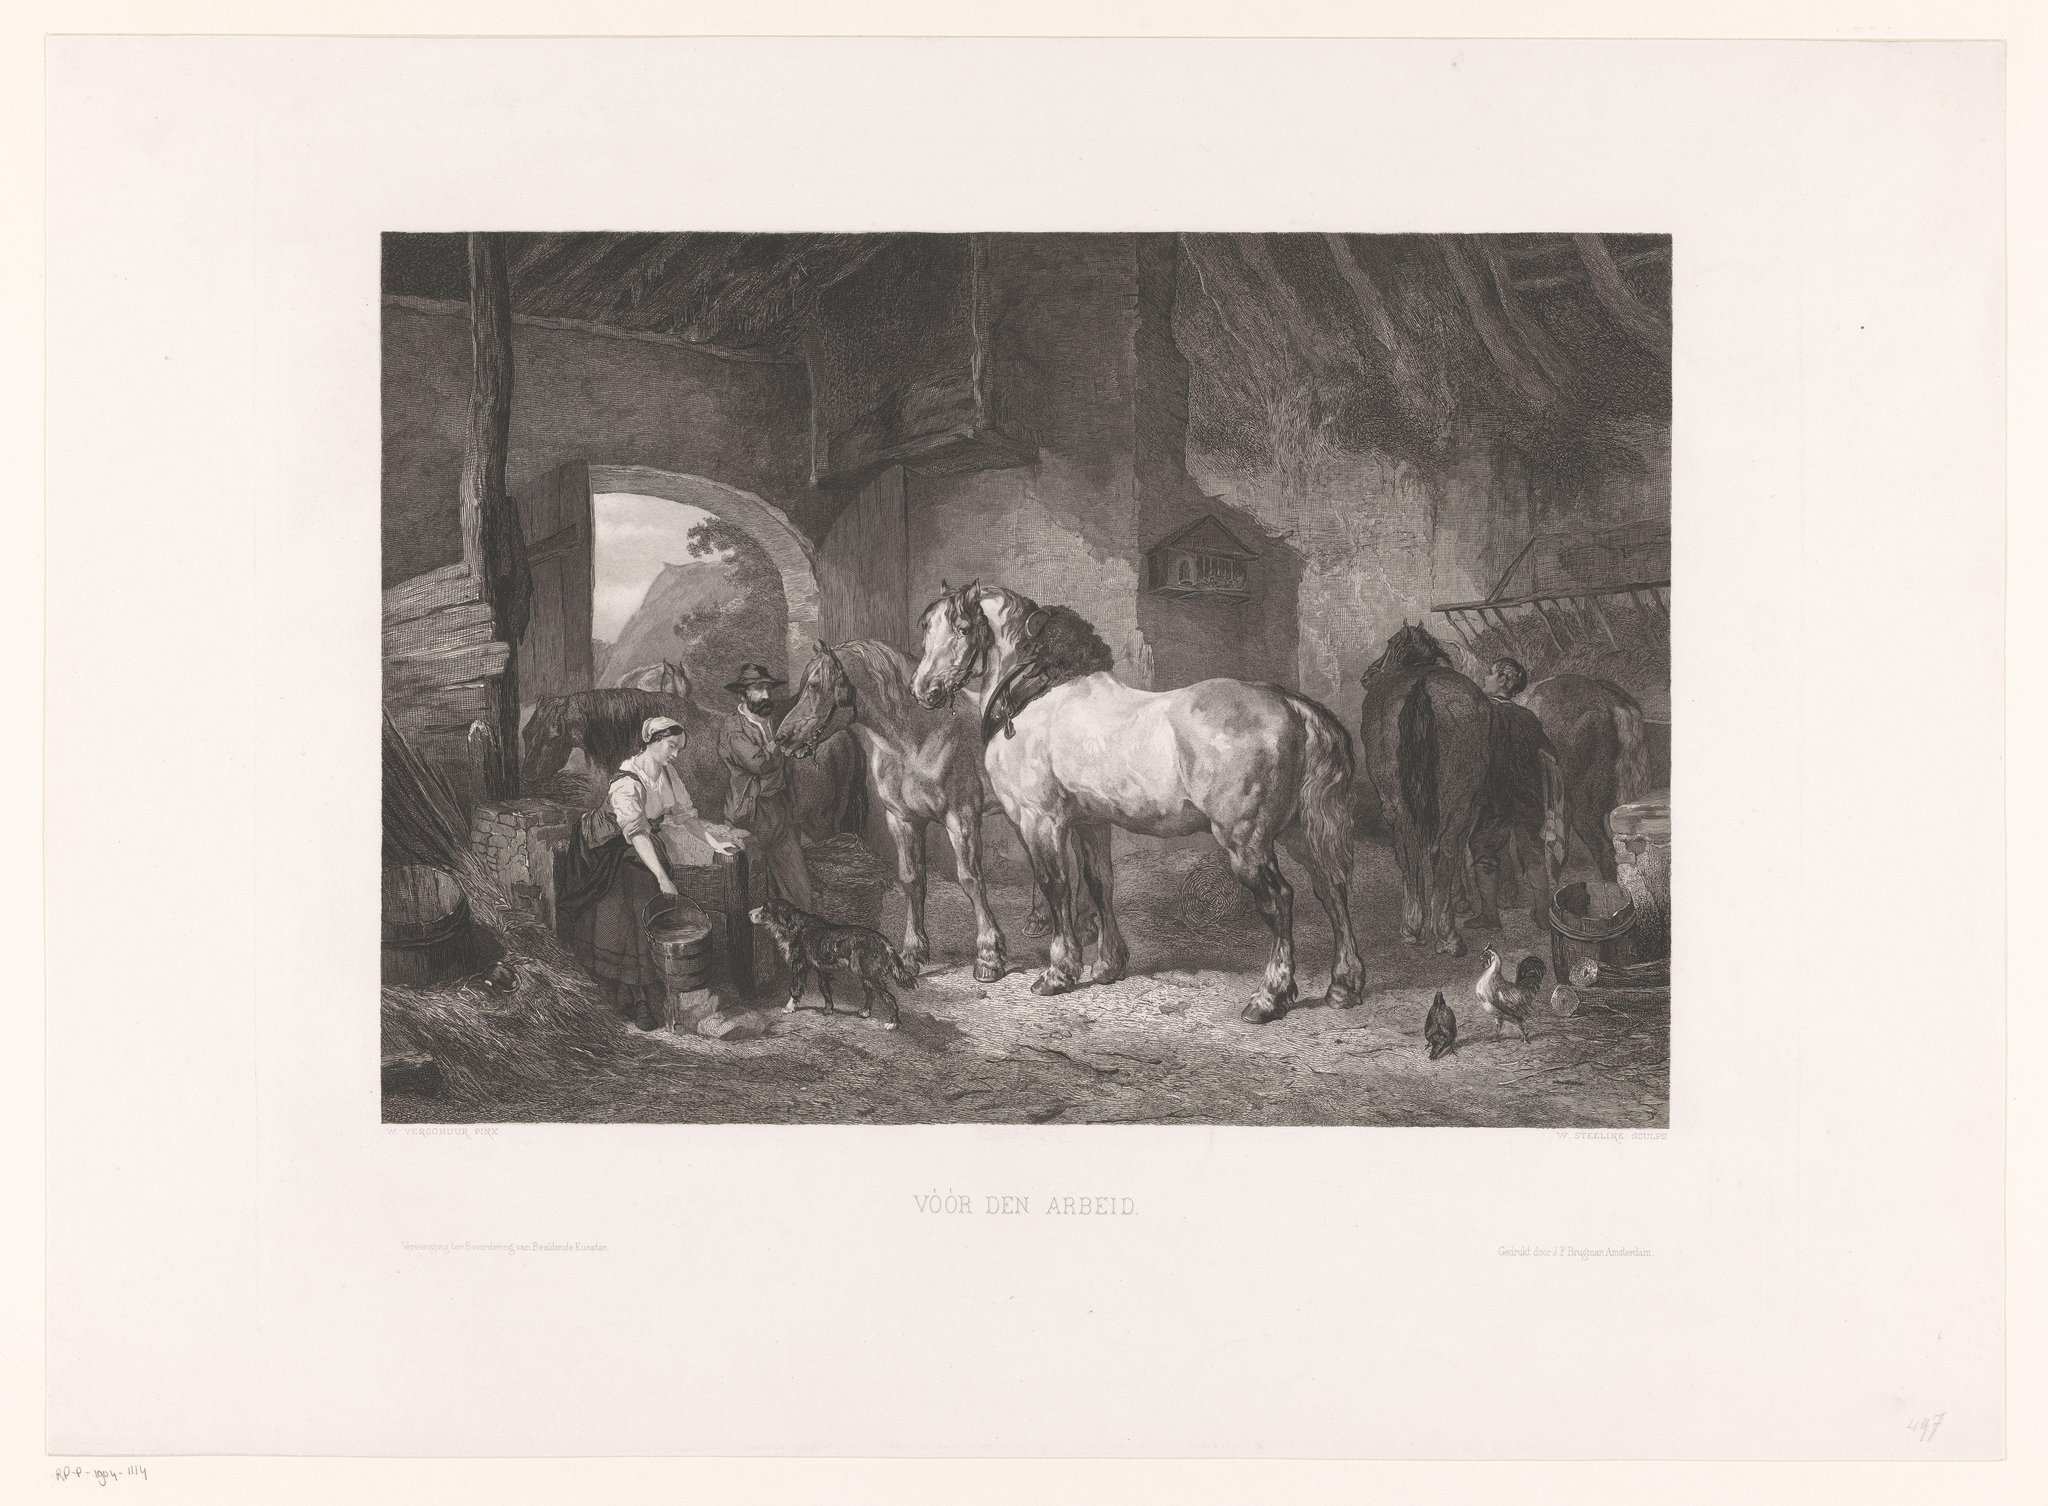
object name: print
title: Vóór den arbeid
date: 1866-1904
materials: paper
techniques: engraving, etching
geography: amsterdam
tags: horse, stall, stable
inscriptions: collector's mark: Lugt 2228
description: Een stal met een boer en boerin bij de paarden. De vrouw tilt een emmer water. Links een open deur. Rechts een open ruif en een jongen bij de paarden.